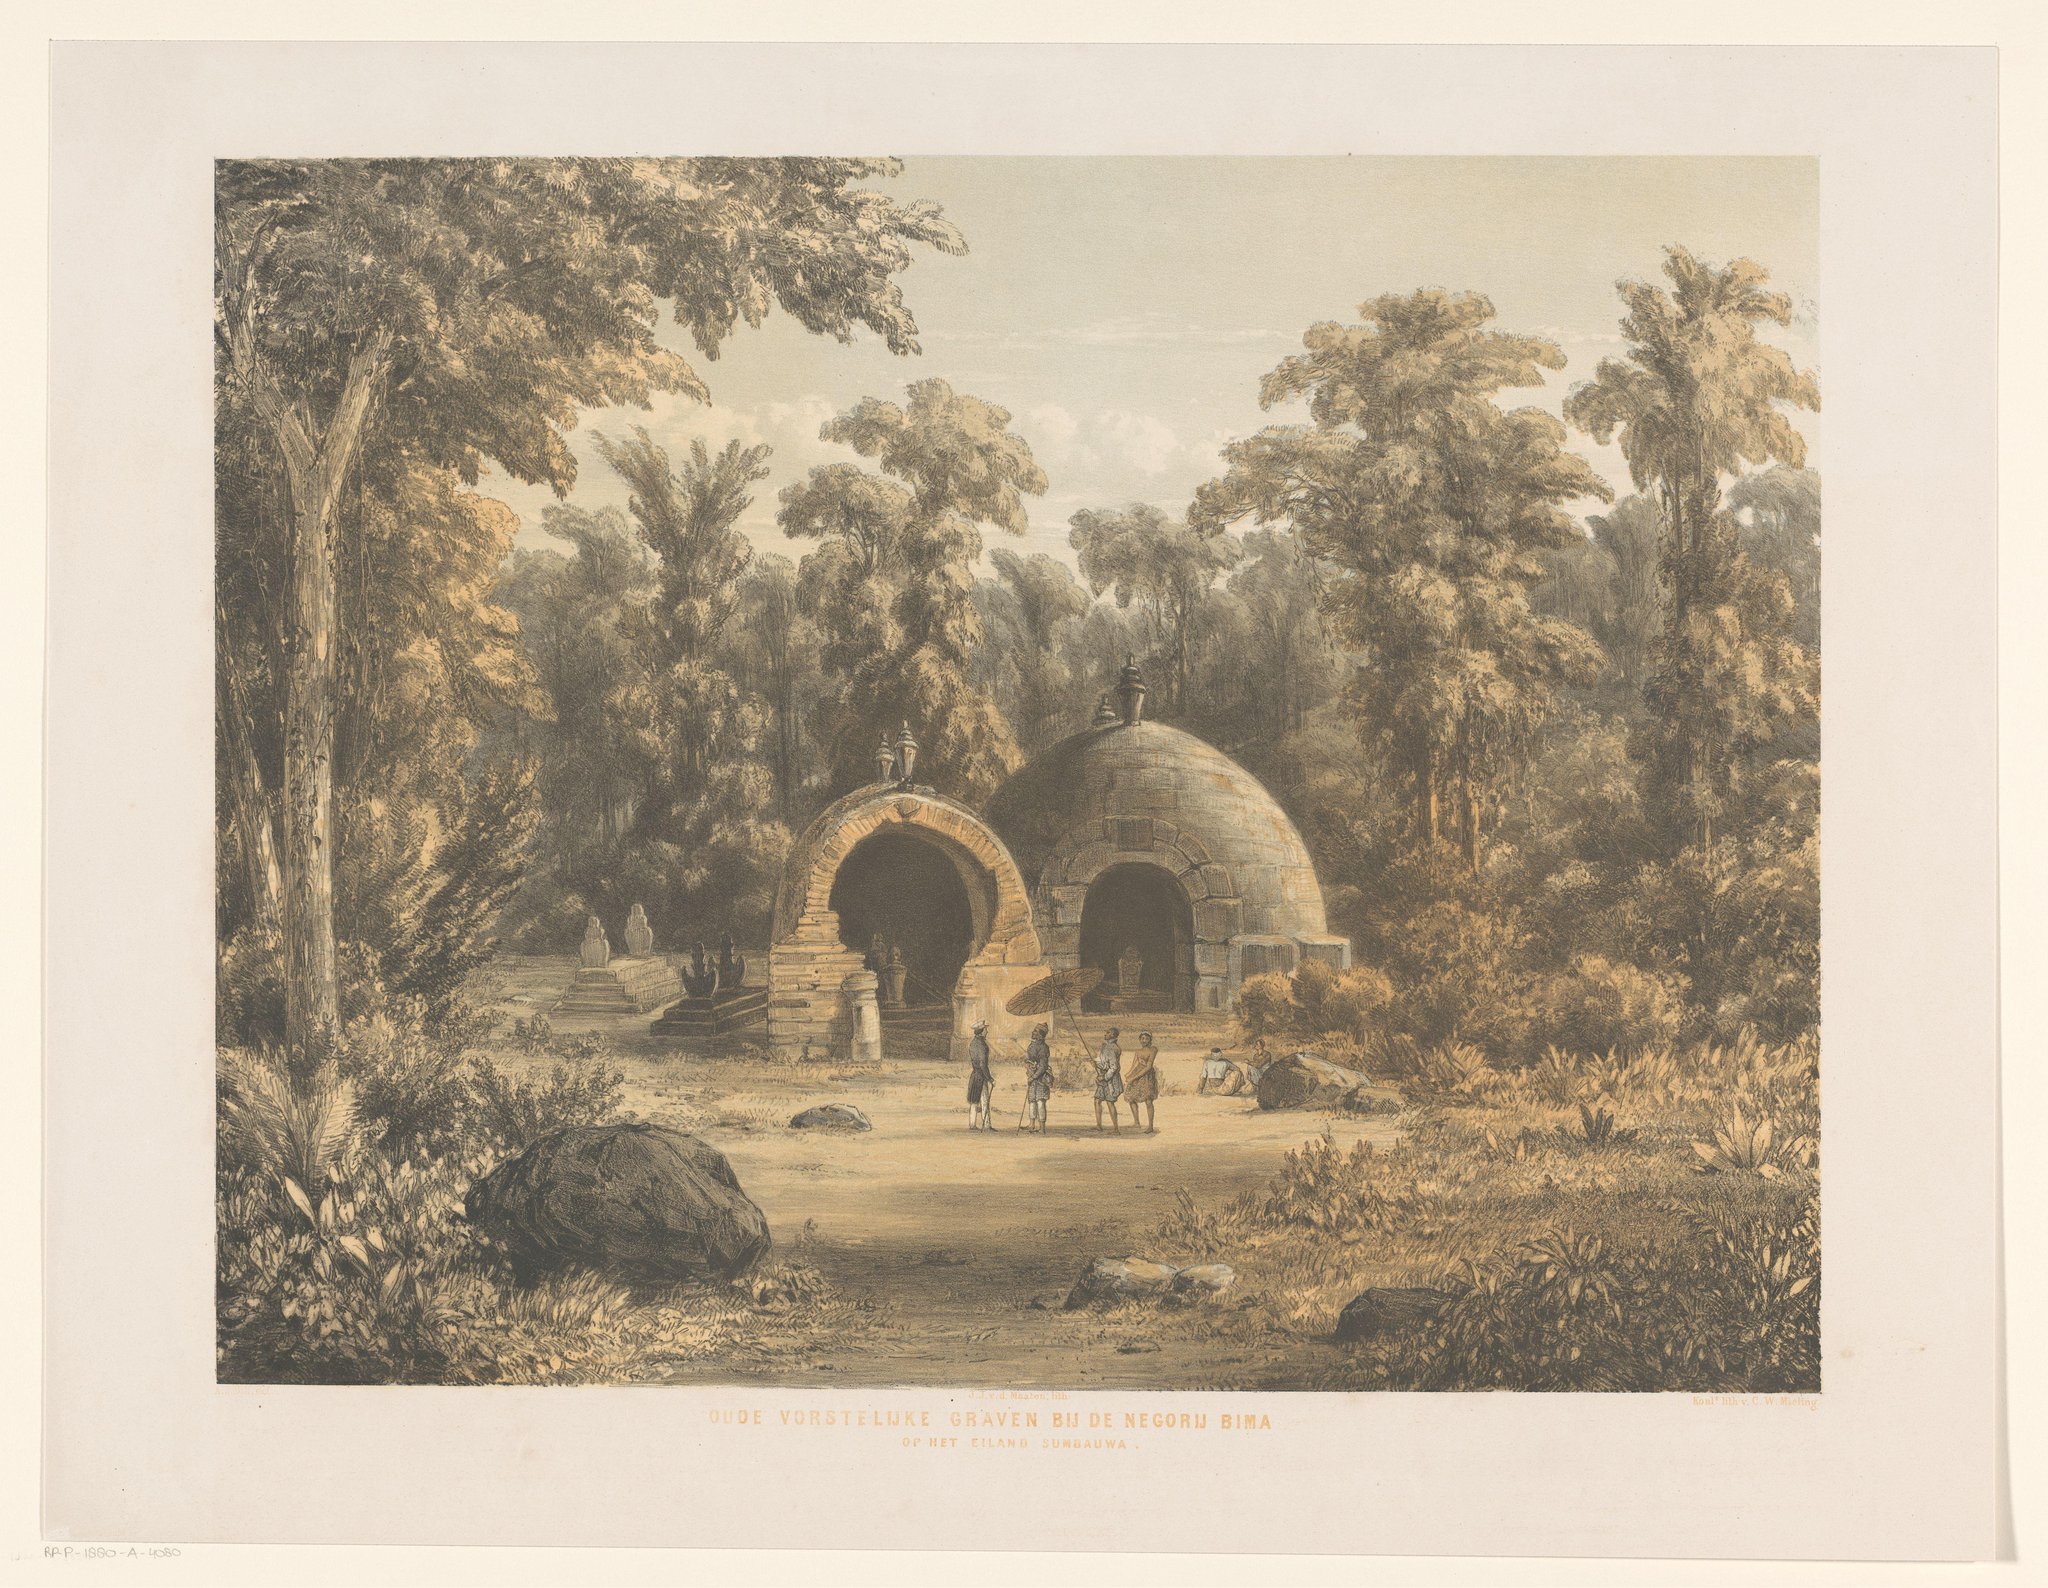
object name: print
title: Oude vorstelijke graven bij de negorij Bima op het eiland Sumbauwa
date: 1852-1856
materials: paper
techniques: lithograph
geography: netherlands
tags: grave, tomb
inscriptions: collector's mark: Lugt 2228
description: Voor twee graven en tombes te Bima (op het eiland Soembawa) is een Europeaan in gesprek met een inlands opperhoofd. Twee dienaren houden hen een parasol boven het hoofd.